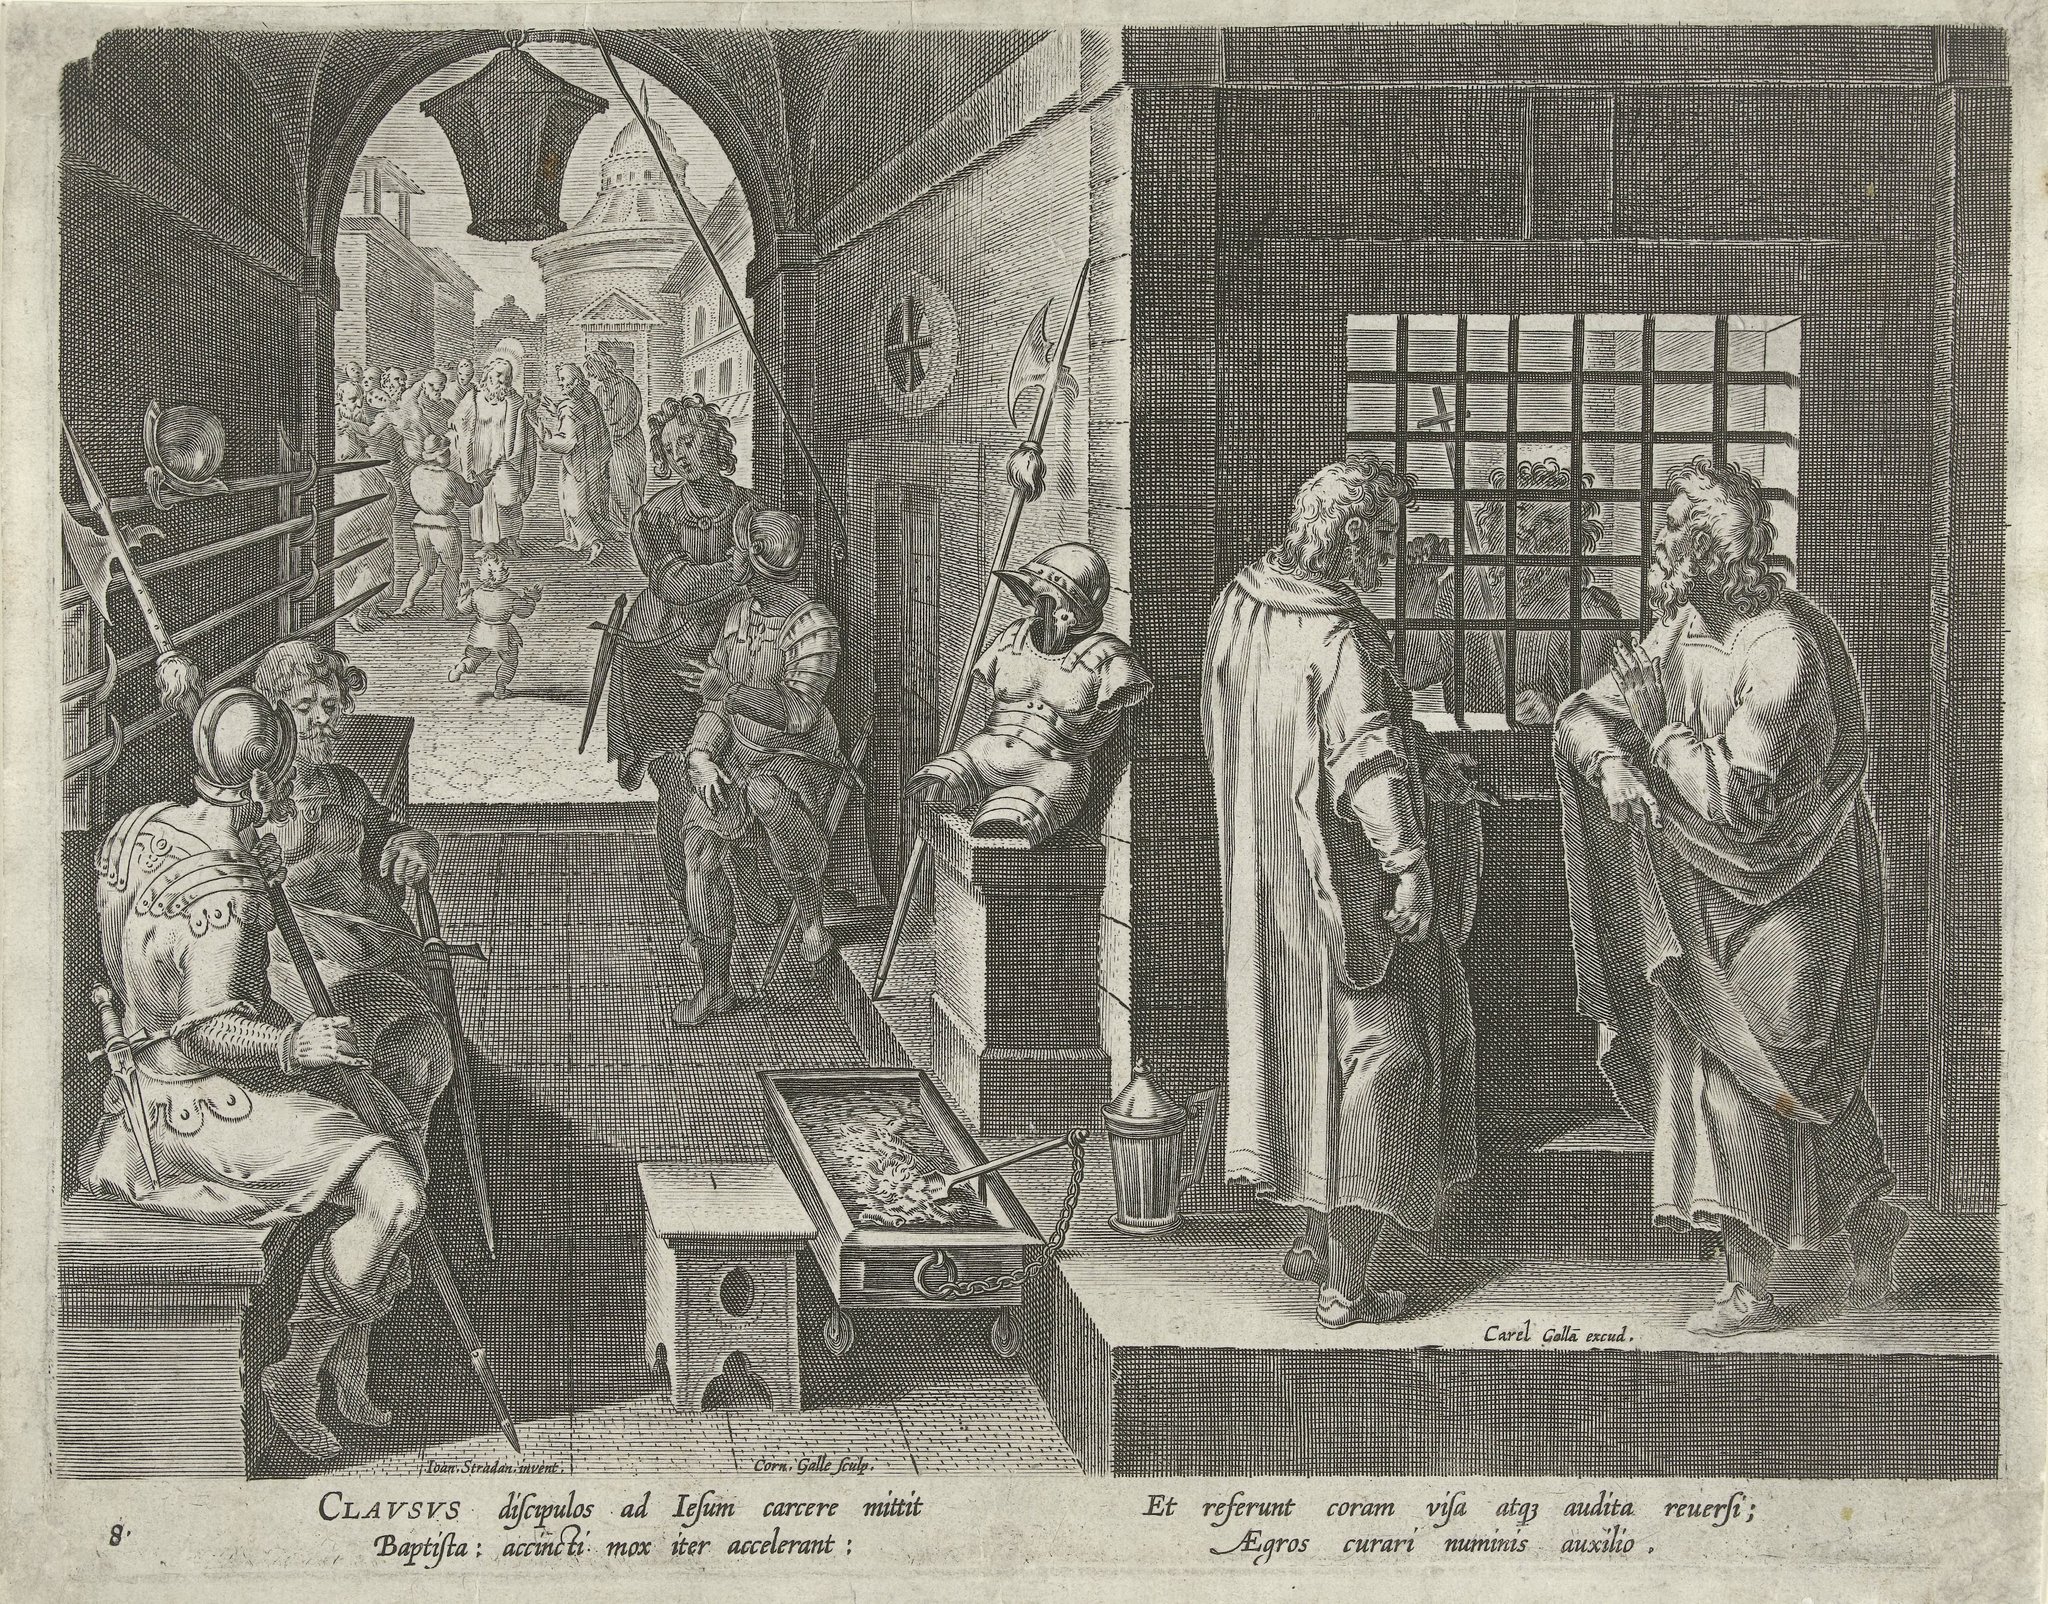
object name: print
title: Johannes de Doper in de gevangenis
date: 1620-1625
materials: paper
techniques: engraving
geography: southern netherlands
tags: john the baptist in prison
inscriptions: signature: ‘Ioan. Stradan. invent.’, caption: ‘CLAUSUS discipulos ad Iesum carcere mittit...numinis auxilio.’, number: ‘4’, collector's mark: Lugt 2760, collector's mark: Lugt 2228, address: ‘Carel Colla excud.’, signature: ‘Corn. galle sculp.’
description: Johannes de Doper in de gevangenis, achter de tralies pratend met twee van zijn volgelingen. Links de gang van de gevangenis waarin soldaten zitten en lansen aan de muur hangen. In de verte de discipelen van Johannes de Doper die zich bij Christus aansluiten.